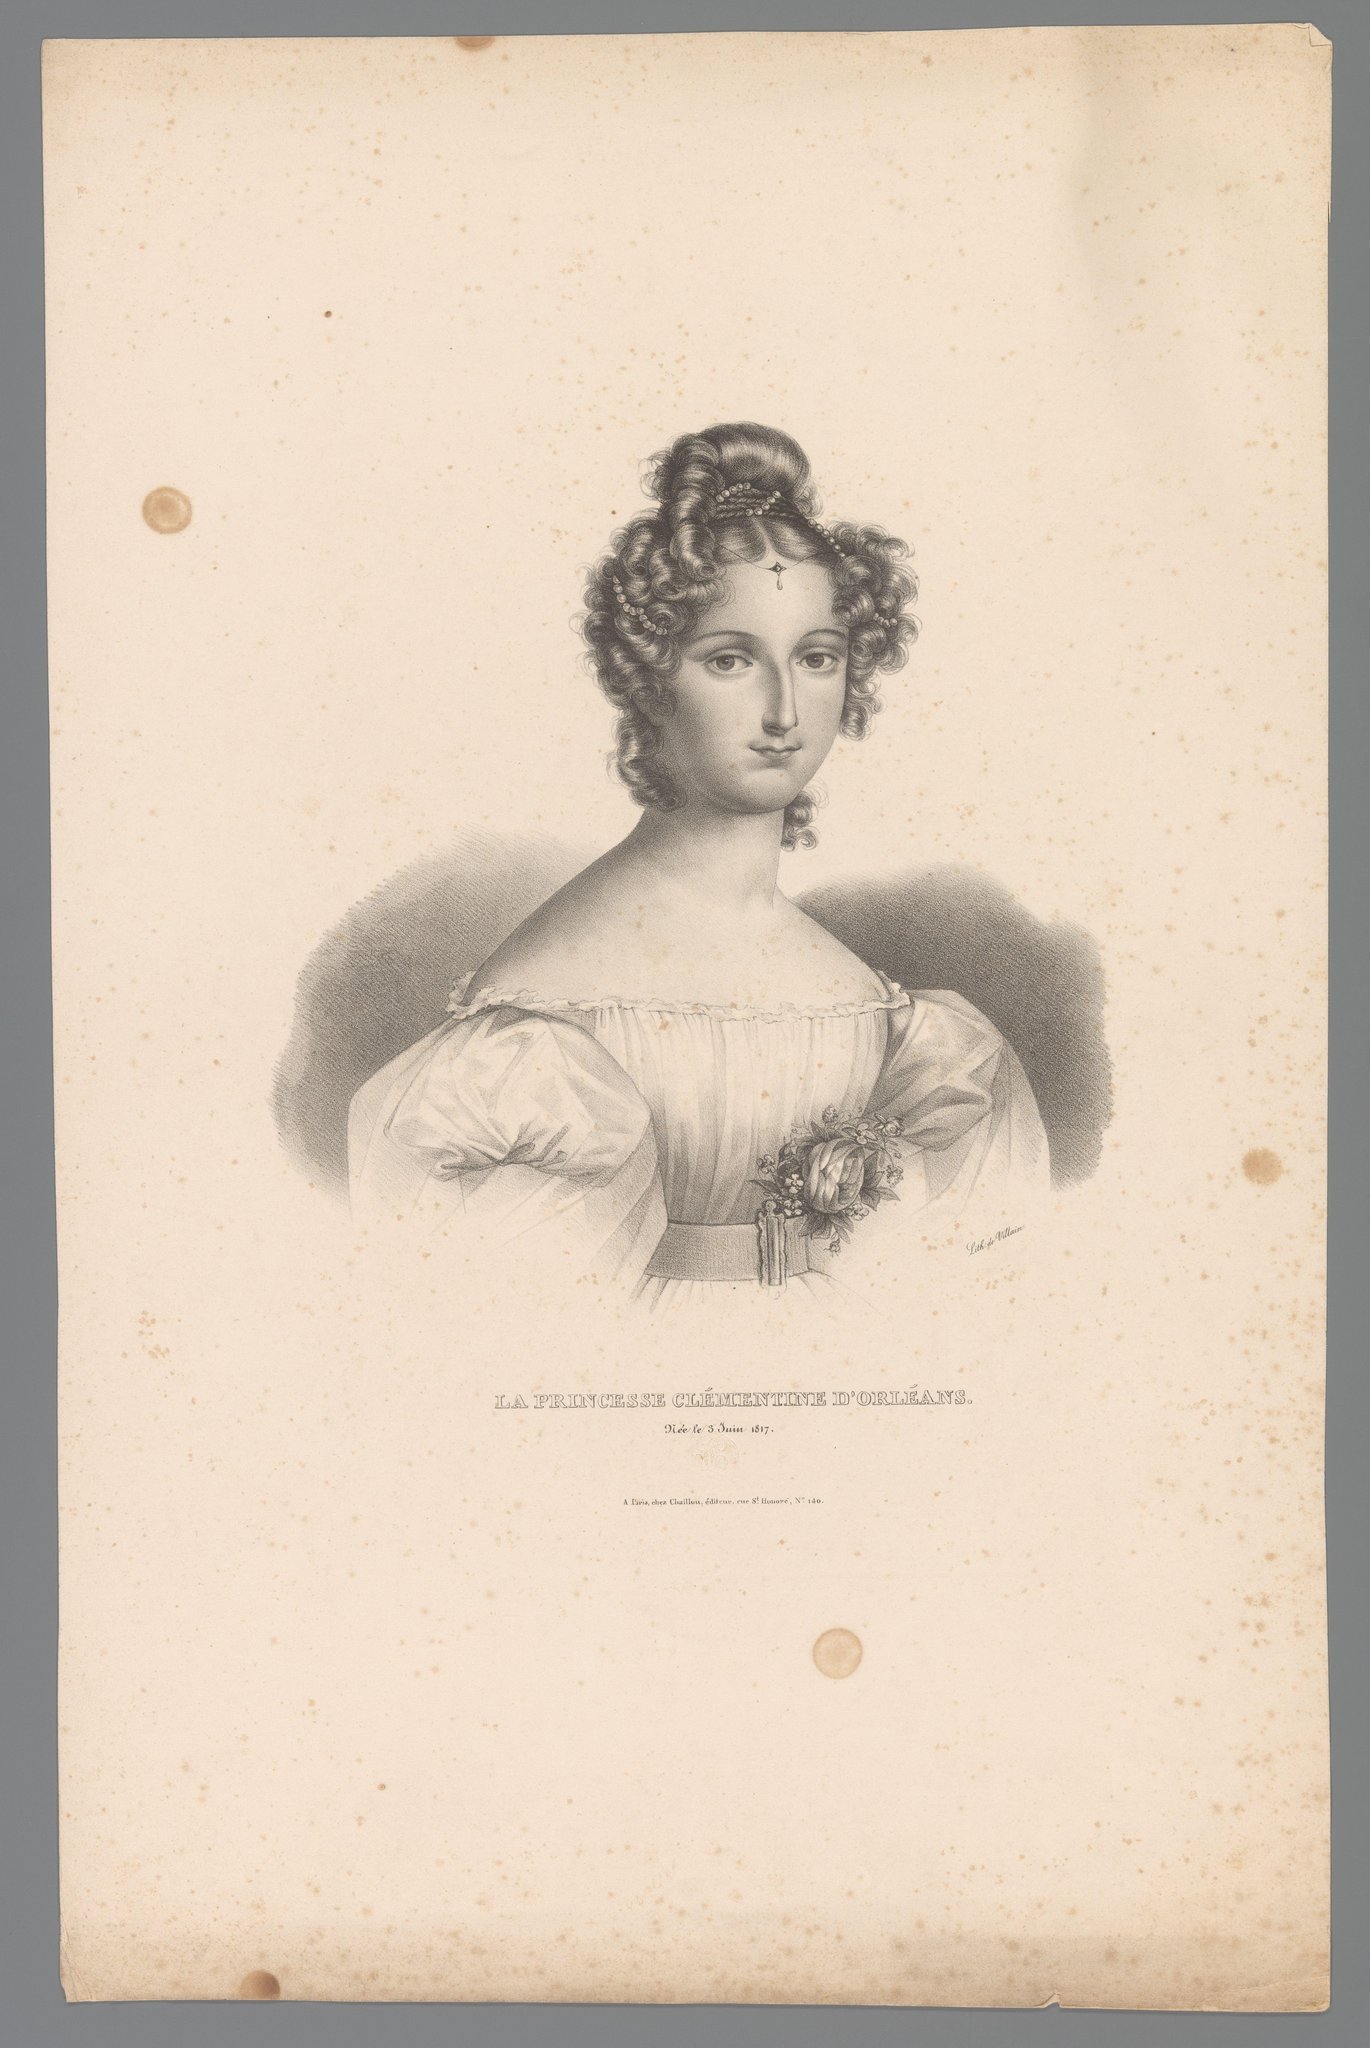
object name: print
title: Portret van prinses Clementine van Orléans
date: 1831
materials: paper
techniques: lithograph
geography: paris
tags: clémentine van orleans, historical persons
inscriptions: collector's mark: Lugt 2228, check stamp: Lugt 619